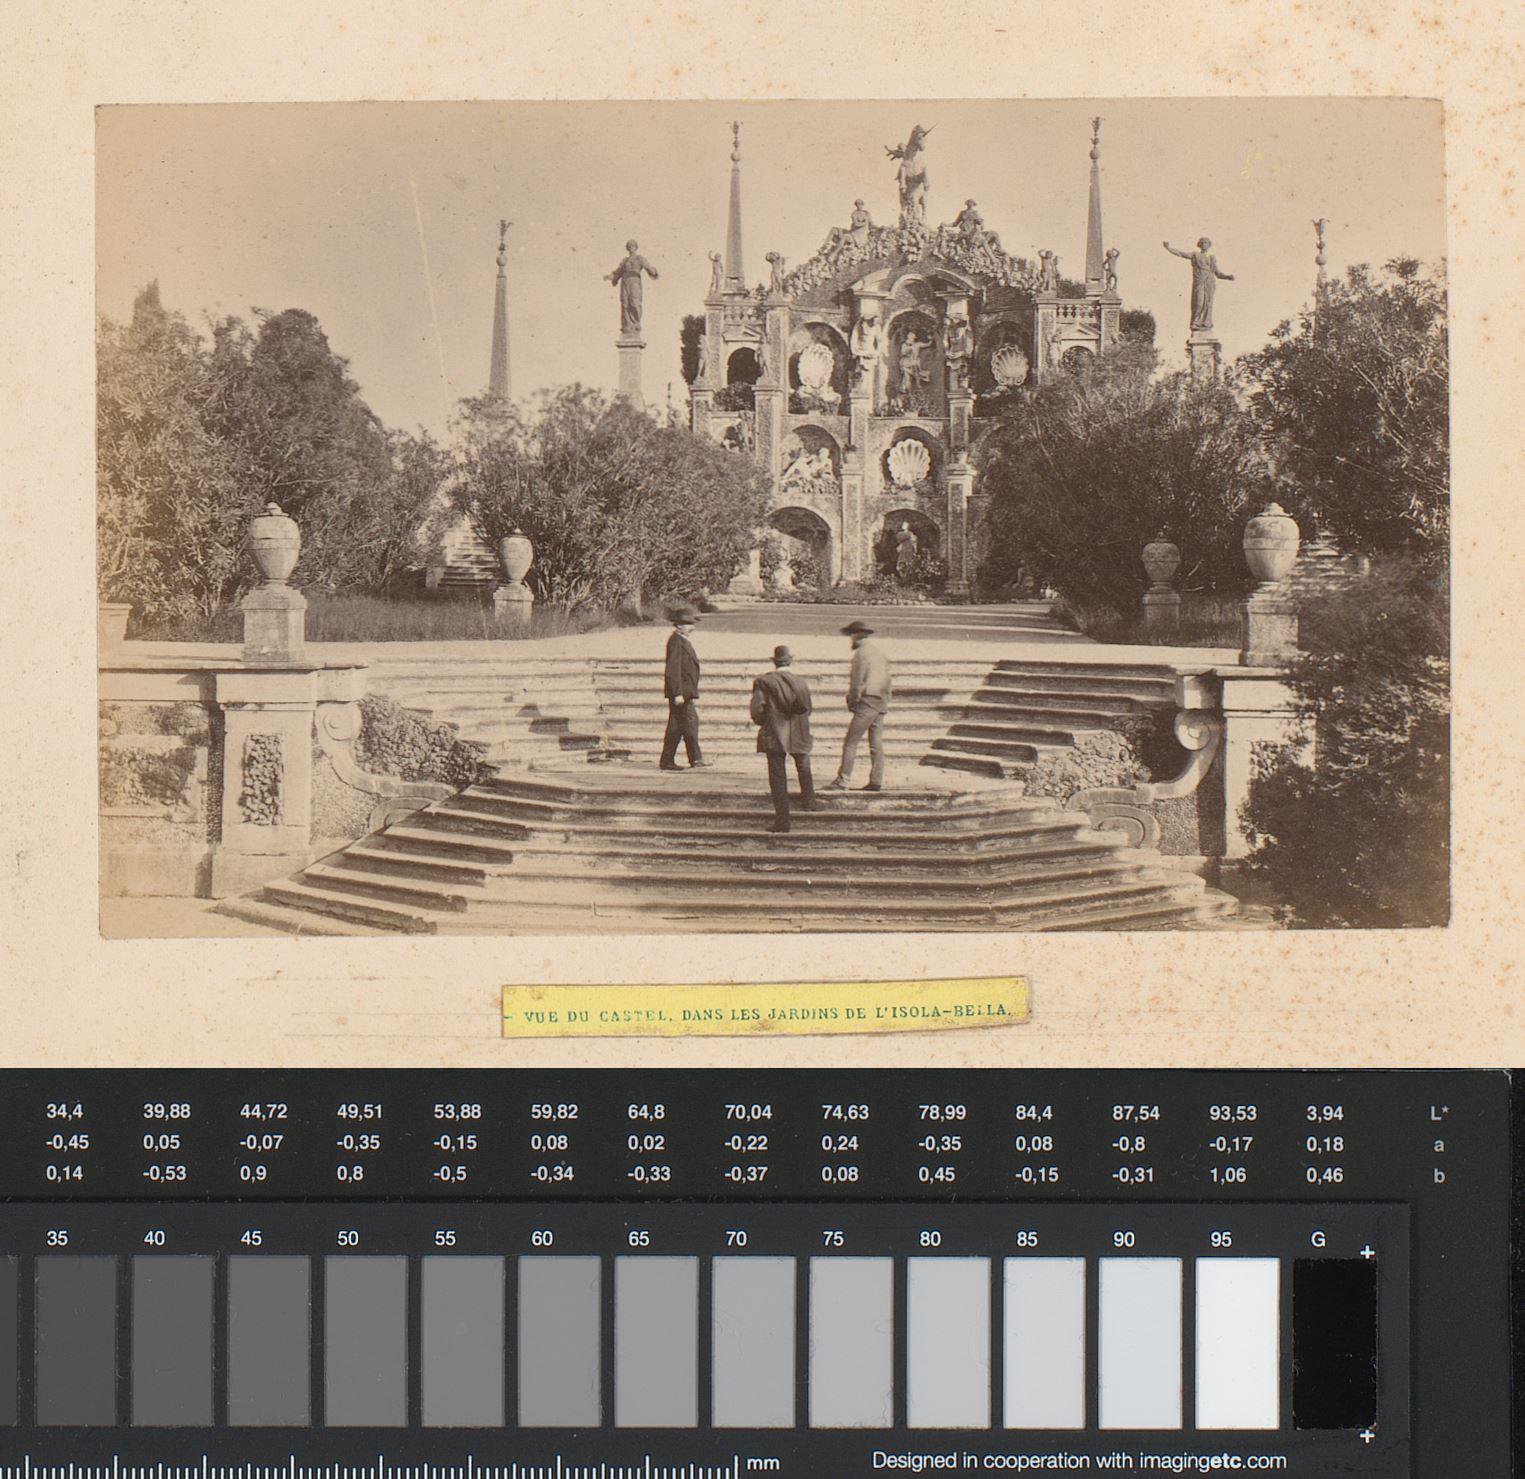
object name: album leaf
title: Drie mannen in de tuin van het Isola Bella, Lago Maggiore, Italië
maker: Anonymous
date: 1860-1890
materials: paper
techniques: albumen print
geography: isola bella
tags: landscapes (+ landscape with figures, staffage), statues, sculptures in garden